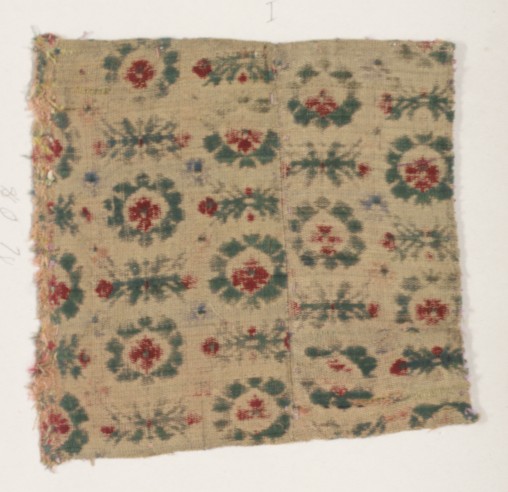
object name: fragment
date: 1701-1800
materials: metal thread, silk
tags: flowers